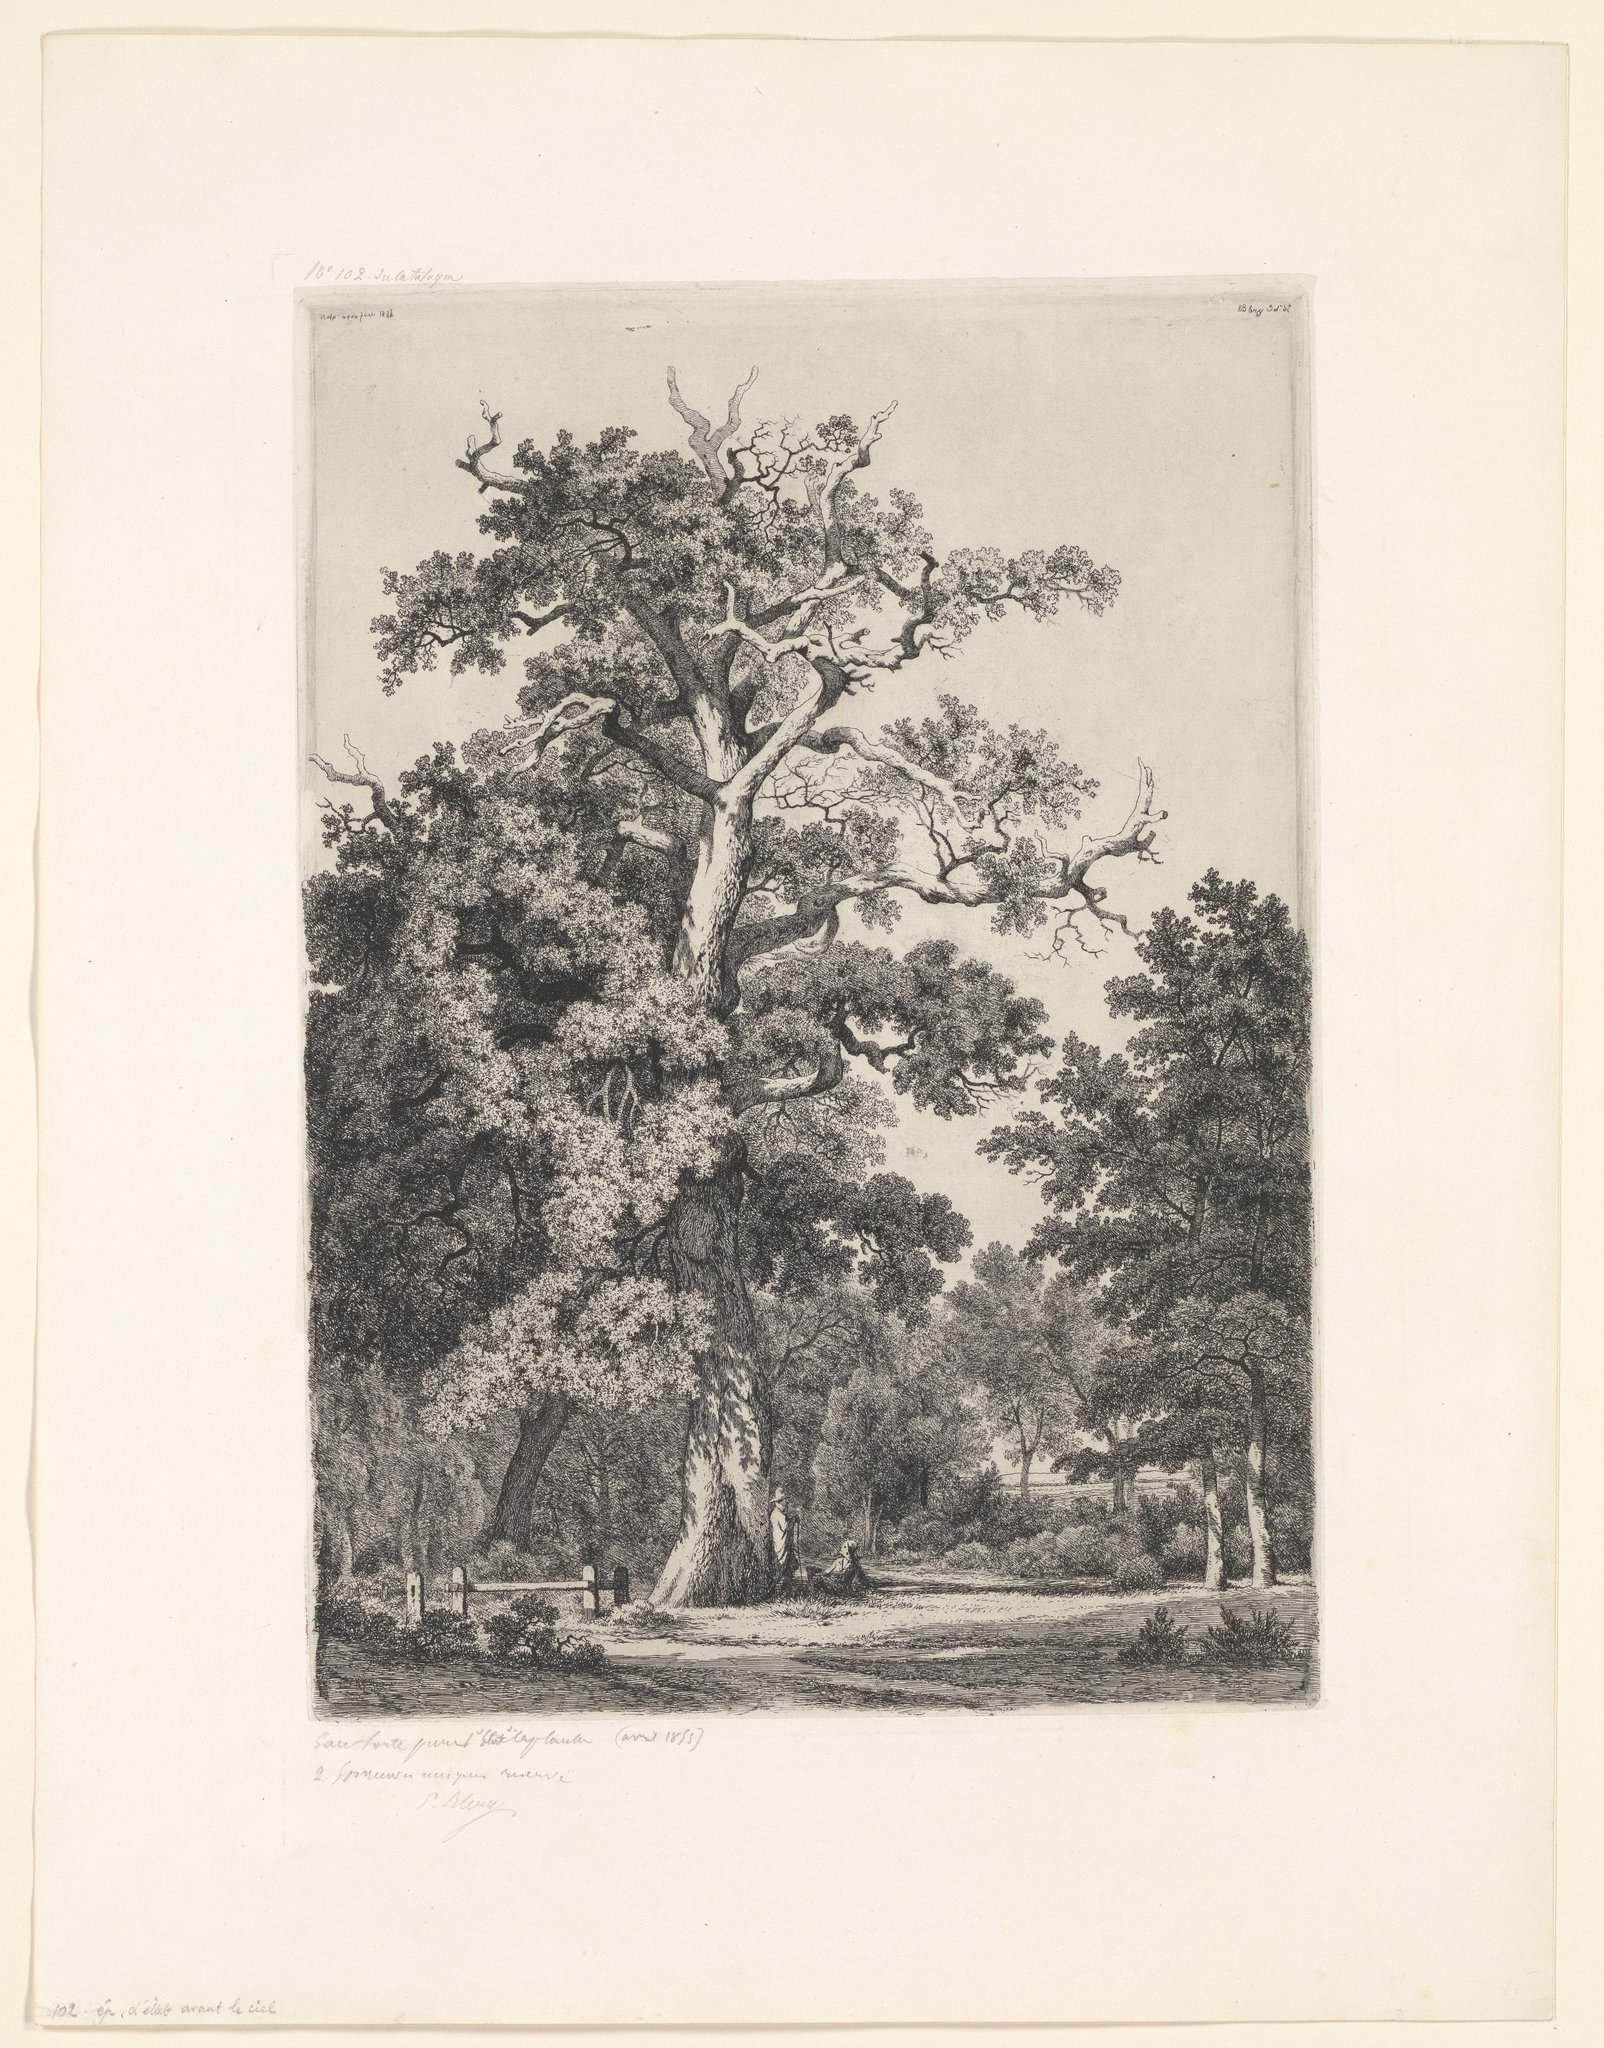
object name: print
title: Oude eik in Bois de Boulogne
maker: eugène bléry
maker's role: print maker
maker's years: 1805-1887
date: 1804-1855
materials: paper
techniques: etching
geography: france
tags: trees: oak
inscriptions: date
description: Twee mensen rusten aan de voet van een grote eik in een boslandschap. Links een hek.